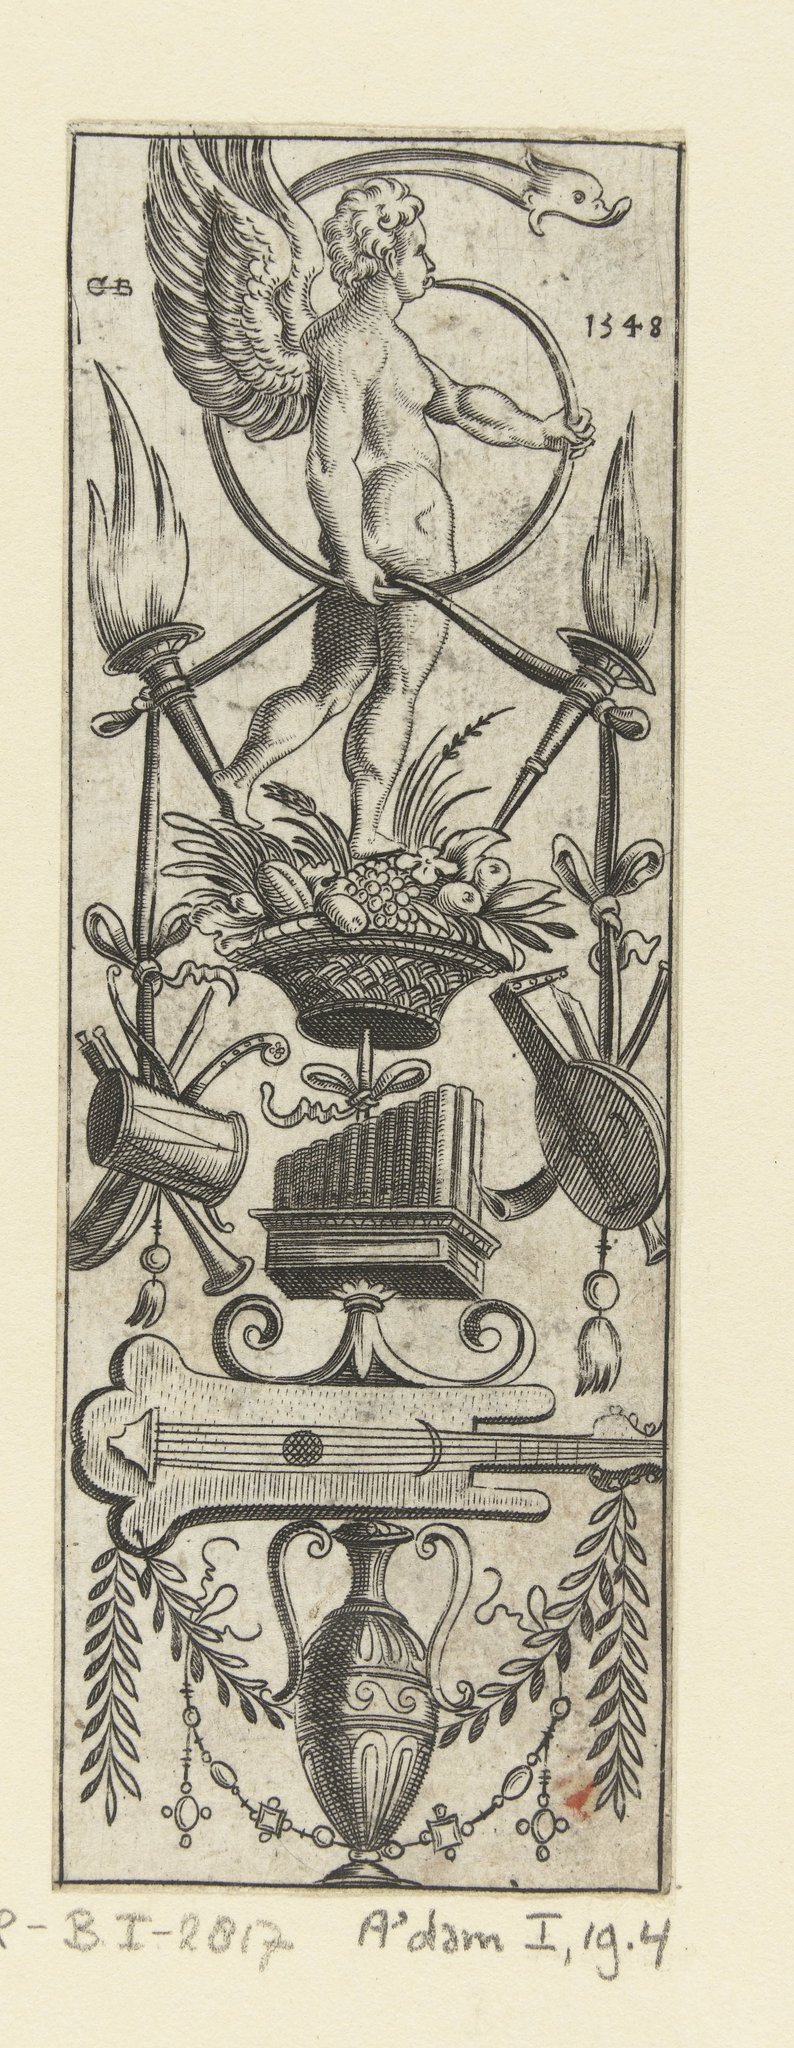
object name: print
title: Gevleugelde figuur met een blaasinstrument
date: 1548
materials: paper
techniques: engraving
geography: netherlands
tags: ornament ~ grotesque, ornament ~ hybrid beings; human and animal forms mixed, fruit, container made of plant material other than wood: basket, wind instruments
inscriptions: date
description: Op een fruitmand staat een gevleugelde figuur met een blaasinstrument. Daaronder hangt links en rechts een trofee van muziekinstrumenten. Een van 4 bladen afkomstig uit een serie van 6.